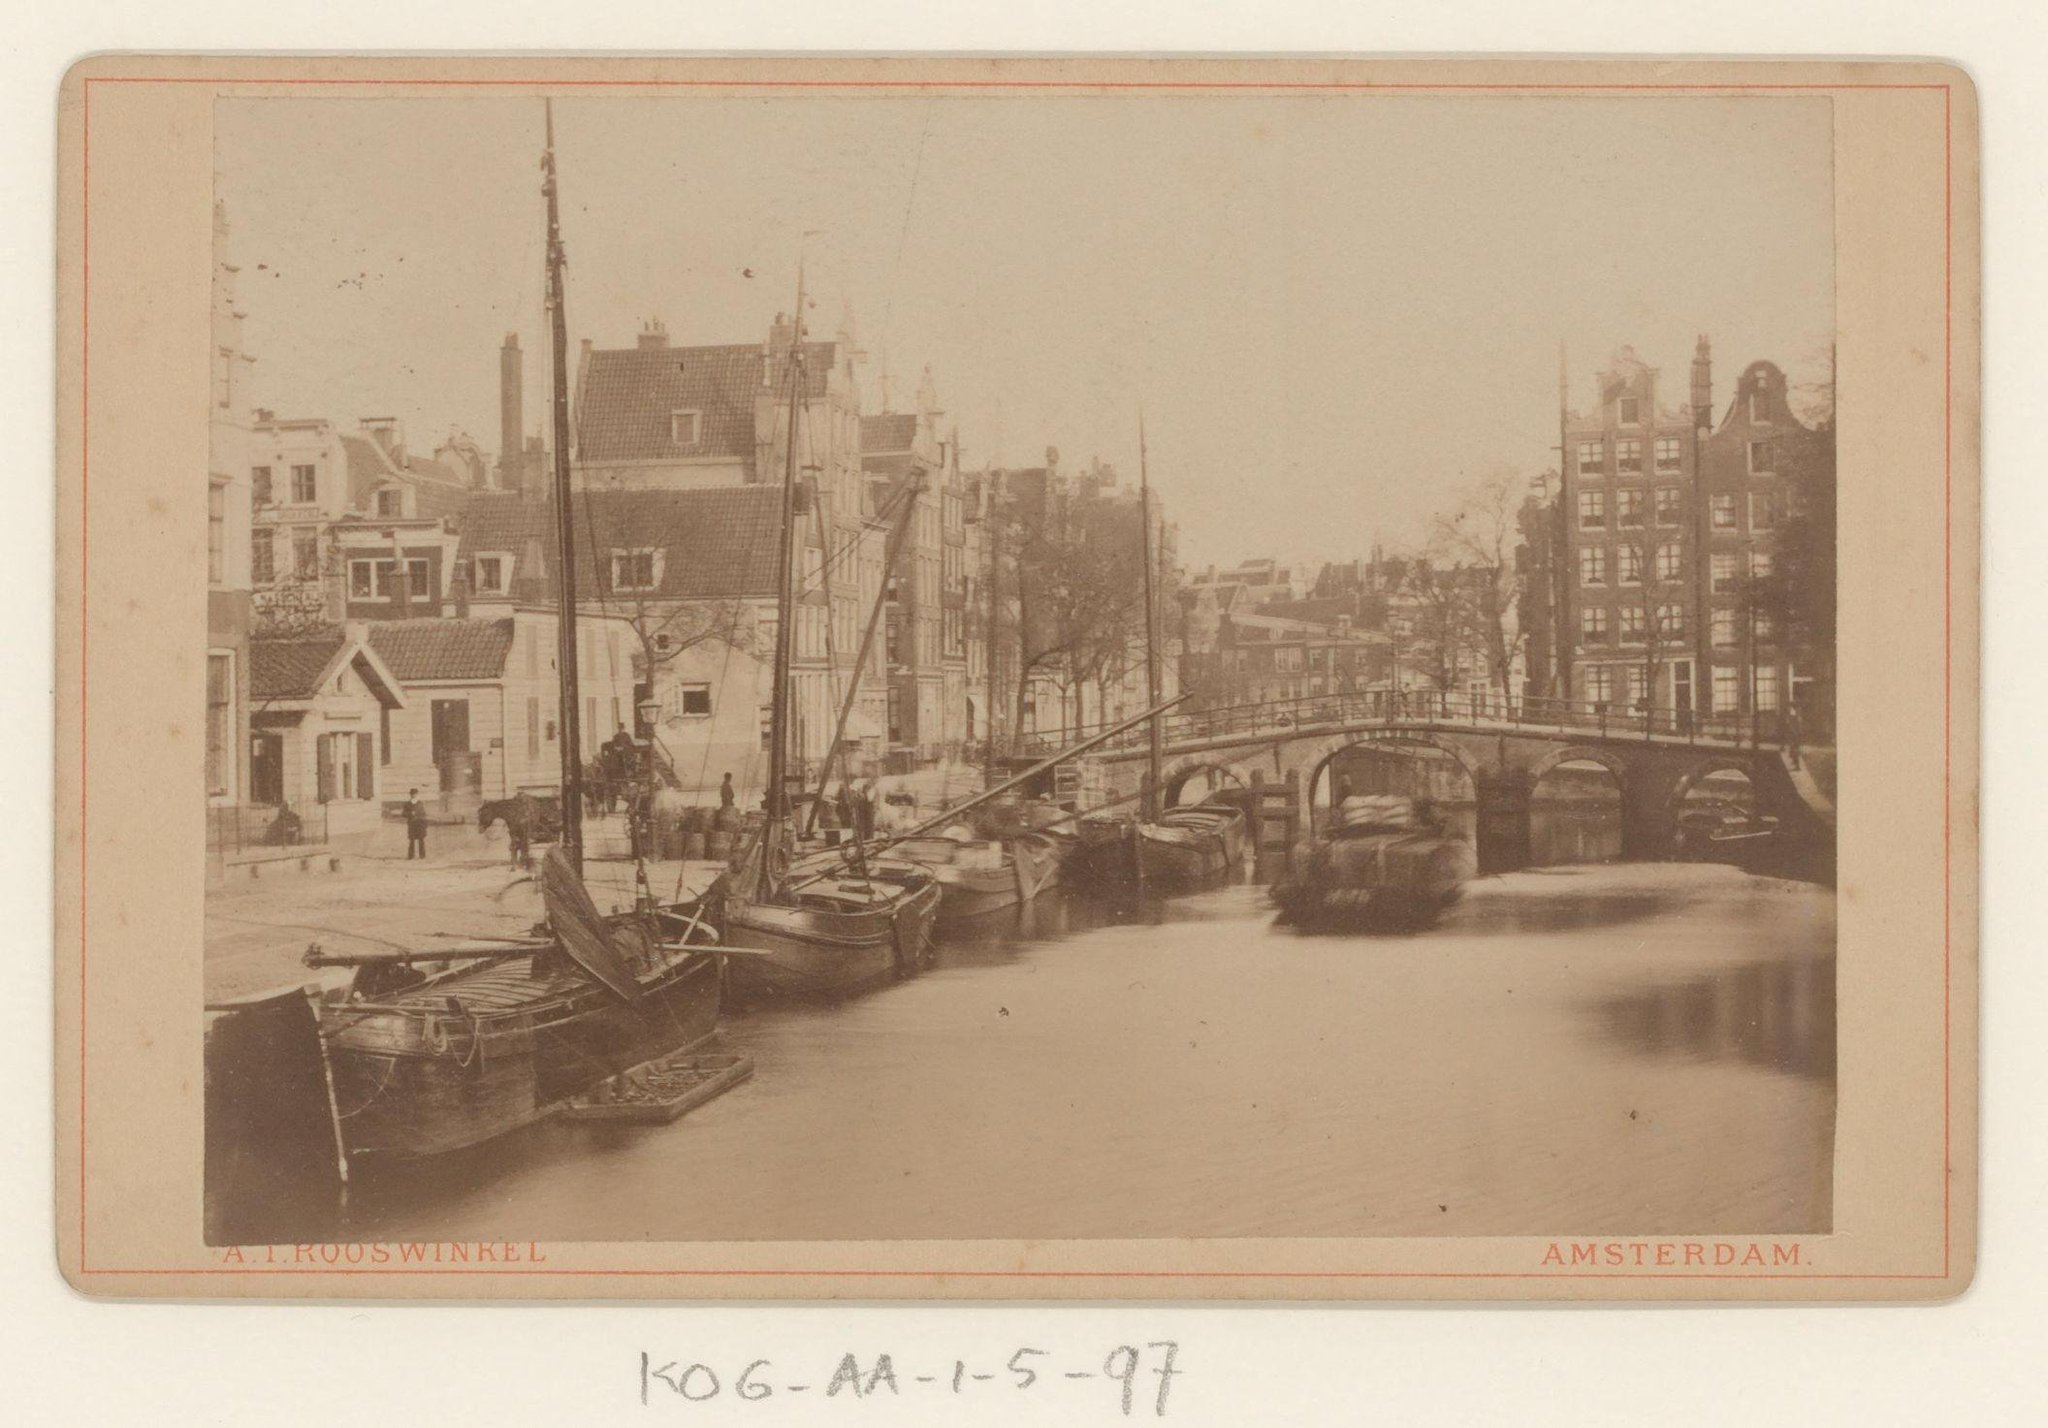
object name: cabinet photograph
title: Gezicht op de Brouwersgracht en de Soeploods op de Herenmarkt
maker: andreas theodorus rooswinkel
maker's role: fotograaf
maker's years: 1838-1909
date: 1875-1896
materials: cardboard, paper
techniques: albumen print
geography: amsterdam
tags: sailing-ship, sailing-boat, city-view in general; 'veduta', canal, bridge in city across river, canal, etc.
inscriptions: inscription: ‘Brouwersgracht / Heerenmarkt / 64’, collector's mark: ‘5’ Lugt 1641b, stamp: ‘Gebr. Douwes / Atelier / Grimburgwal 15 / Amsterdam’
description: Rechts van de soeploods Brouwersgracht 62, 60 en 58. Onderwerpsrubriek binnen de Atlas Amsterdam: Begijnensloot (Gedempte), Bagijnhofsteeg, Beulingsloot, Bickersgracht en –plein, Bickersstraat (Groote), Bilderdijkskade en -straat, Binnenkant, Blauwburgwal, Boomdwarsstraat, Brouwersgracht, Bleekersspad (Lange), Bleekerssloot, Bloemgracht, Boerenwetering, Boltensgrachtje, Boomssloot (Recht), Badhuisweg.